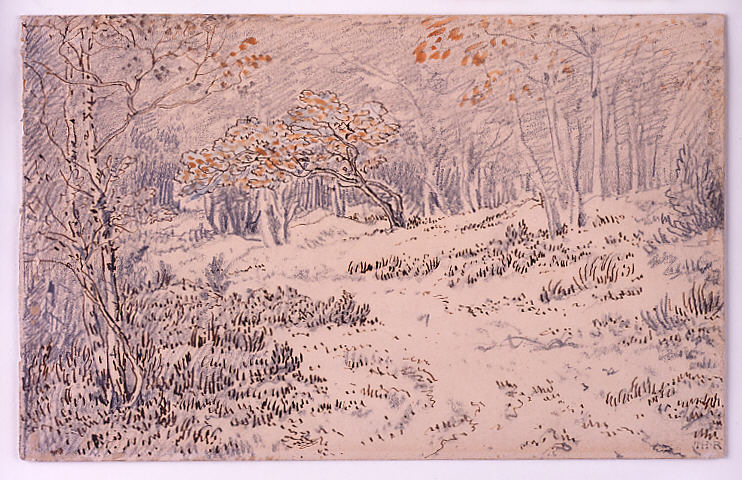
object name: drawing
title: Autumn Landscape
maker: théodore rousseau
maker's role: artist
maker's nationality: french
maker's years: 1812-1867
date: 1855-1865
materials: graphite, ink, paper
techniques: wash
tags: landscapes,autumn